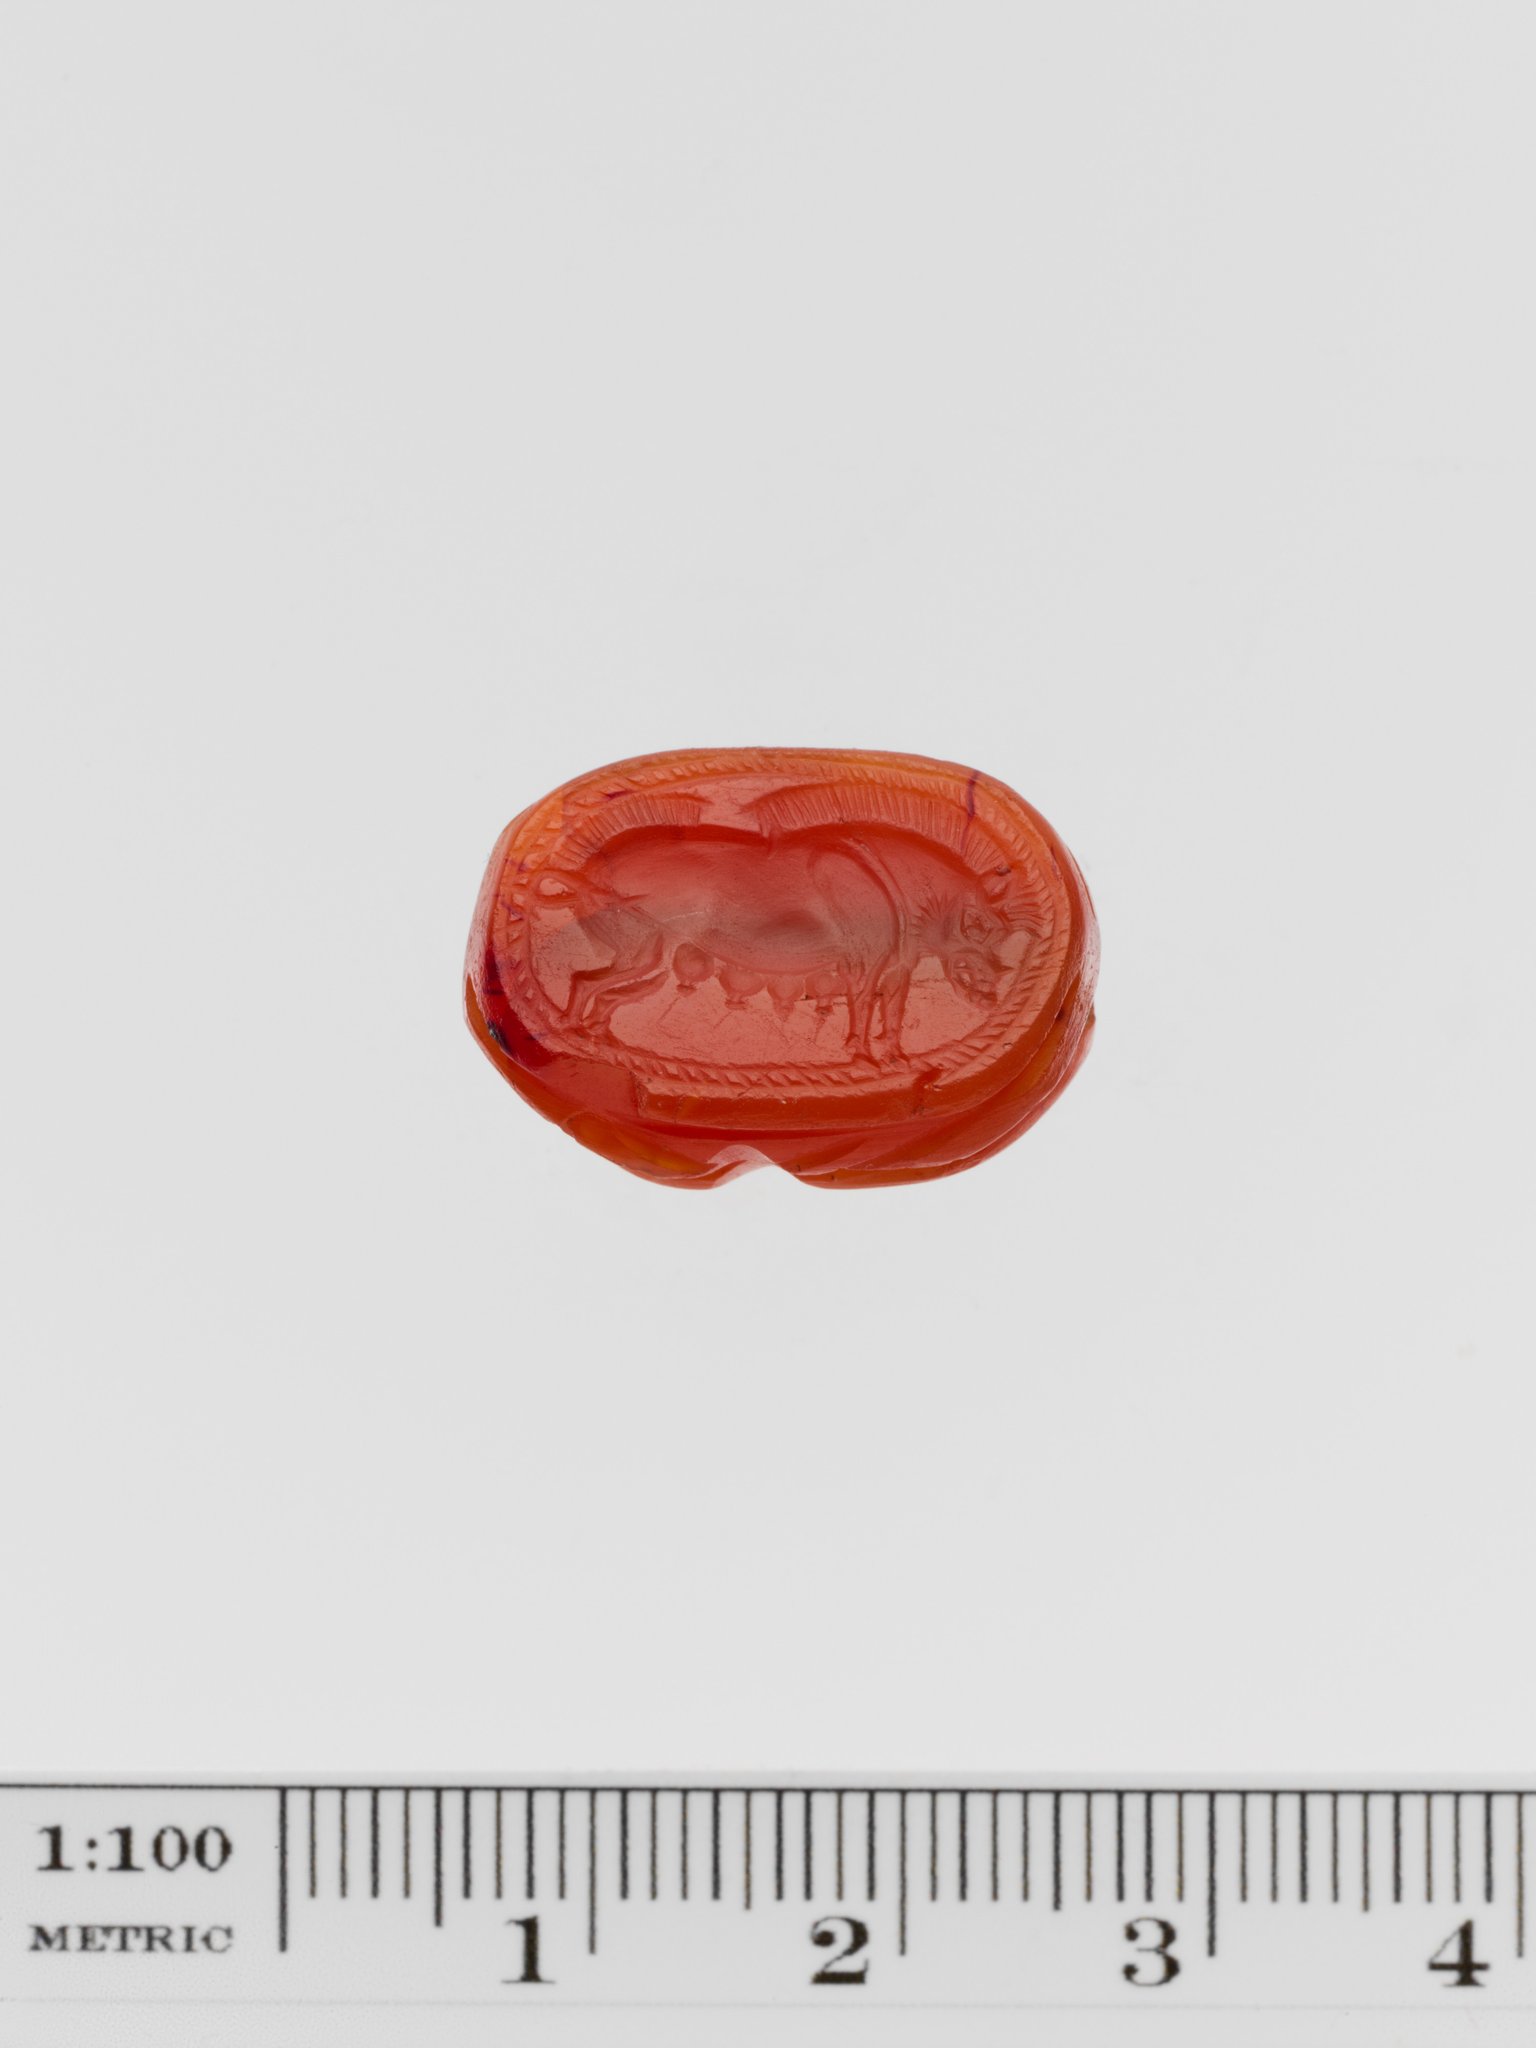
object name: scarab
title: Carnelian scarab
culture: greek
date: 534-468 BCE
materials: gemstone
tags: scarabs